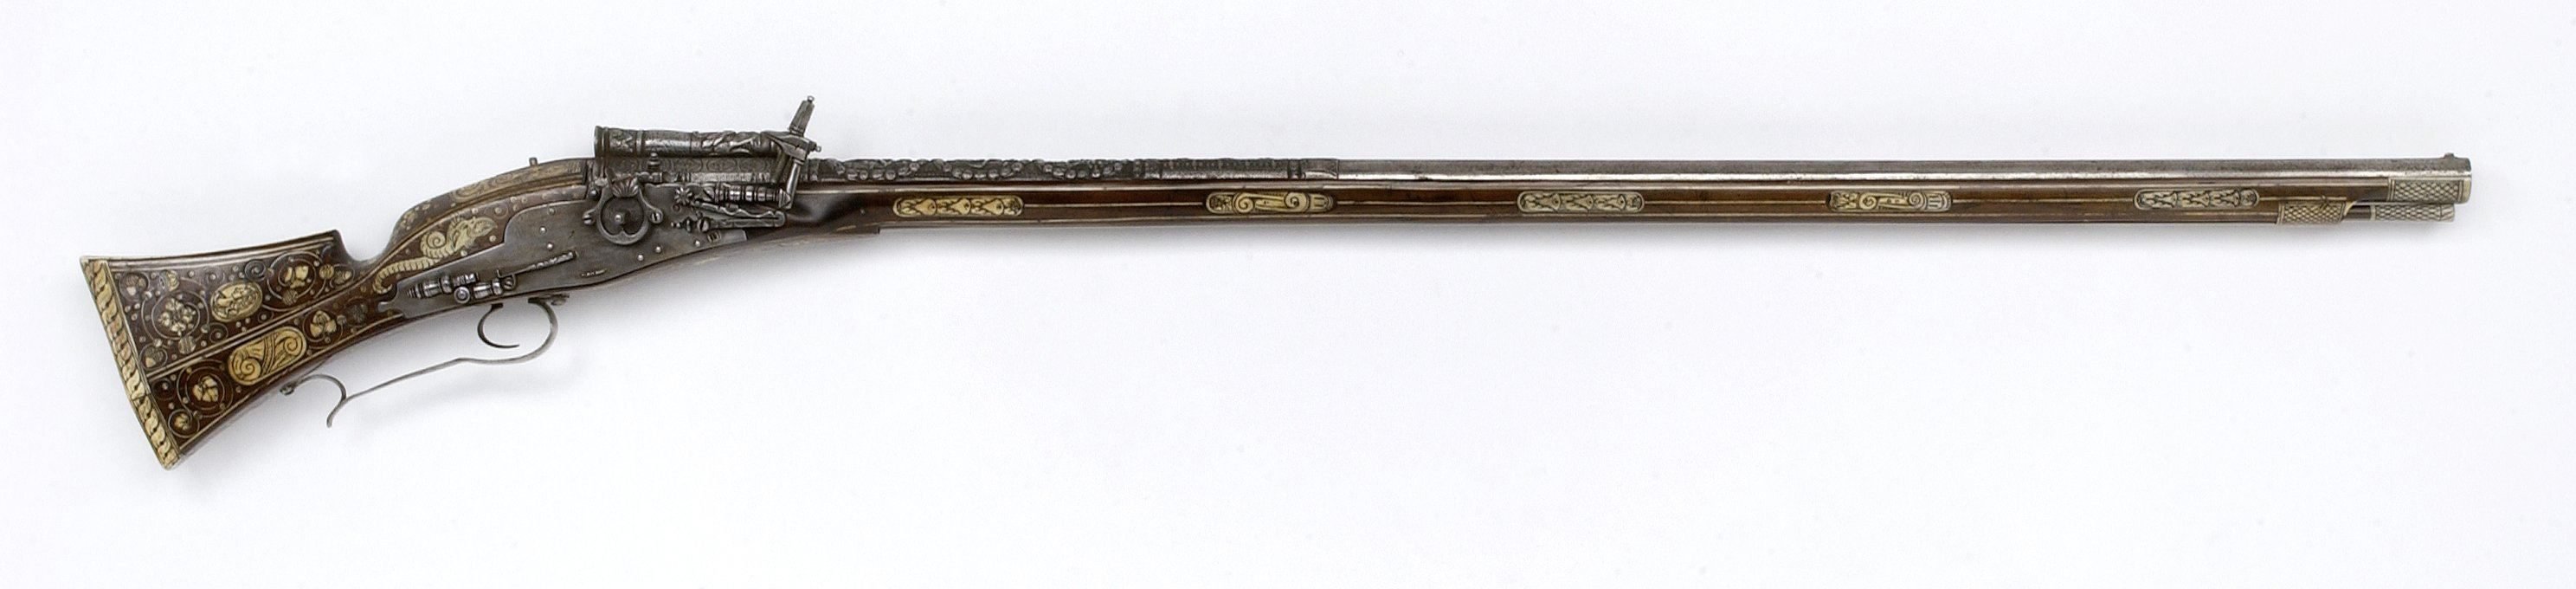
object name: radslotkarabijn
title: Radslotgeweer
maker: Anonymous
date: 1625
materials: horn, iron, silver, wood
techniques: casting, metalworking, encrustation, engraving, inlay, relief, turning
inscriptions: mark